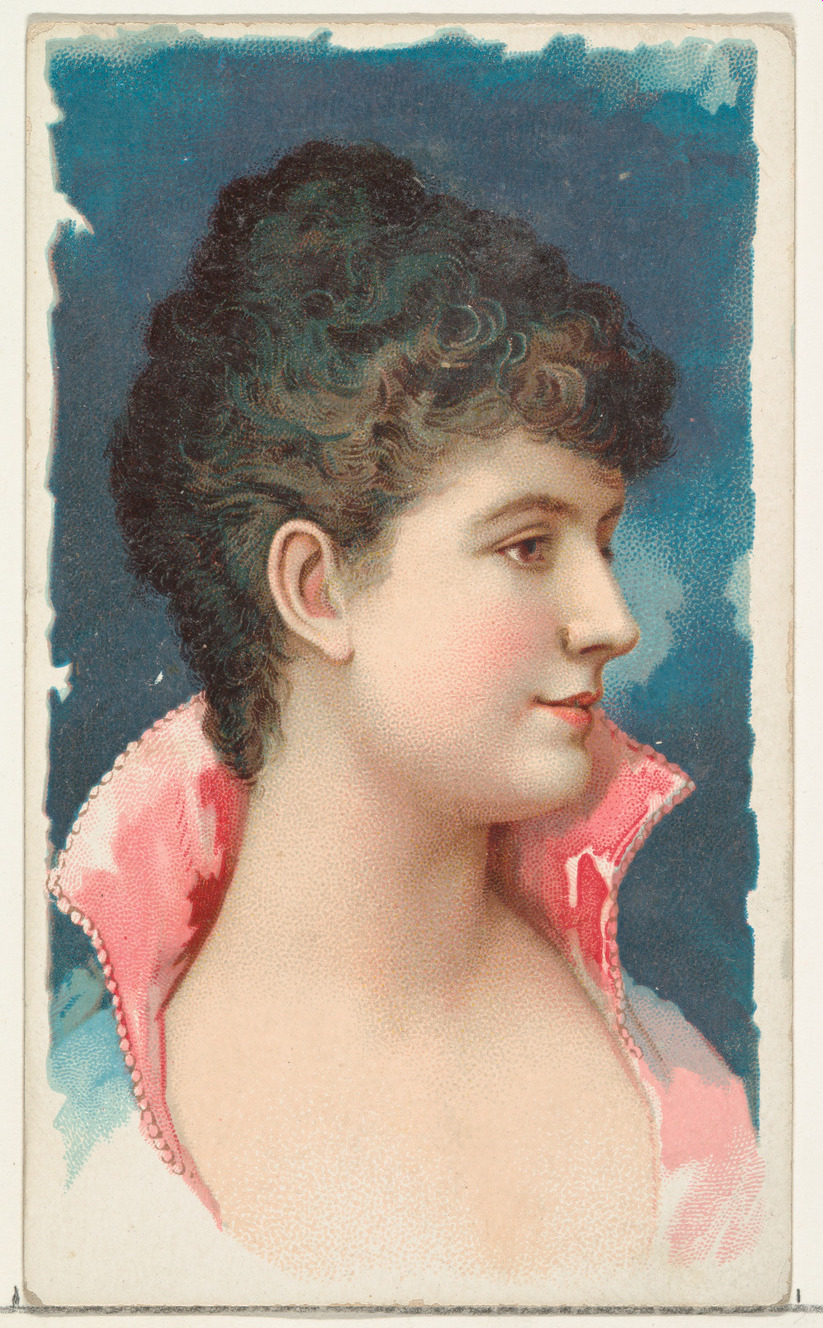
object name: print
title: Actress wearing bodice with pink collar, from Stars of the Stage, First Series (N129) issued by W. Duke, Sons & Co. to promote Honest Long Cut Tobacco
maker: w. duke, sons & co.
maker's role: publisher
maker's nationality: american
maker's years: 1870-1920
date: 1890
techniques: color lithograph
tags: profiles,women,actresses